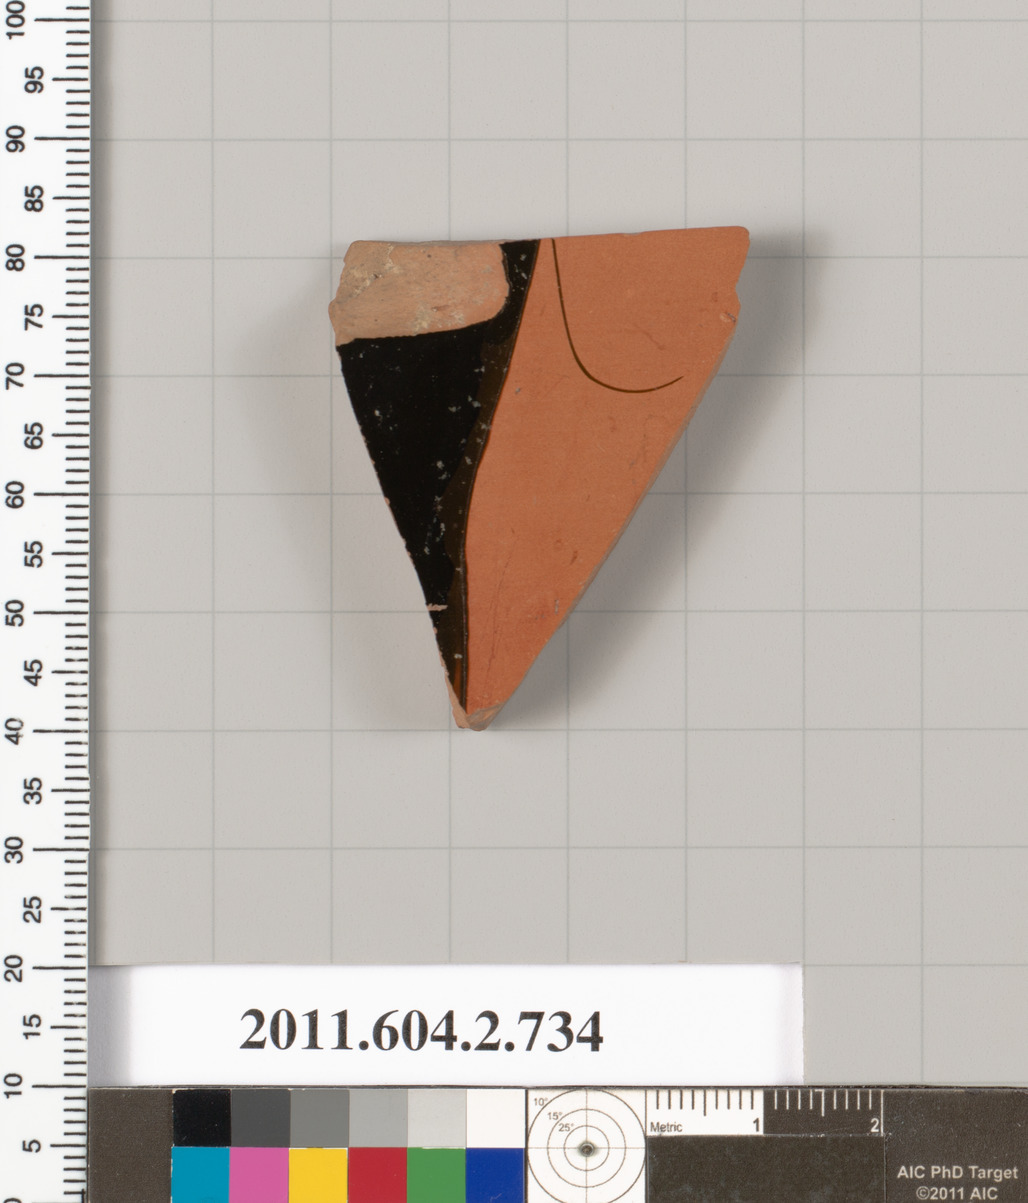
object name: calyx krater fragment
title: Terracotta fragment of a calyx-krater (bowl for mixing wine and water)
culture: greek, attic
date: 460-450 BCE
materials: terracotta